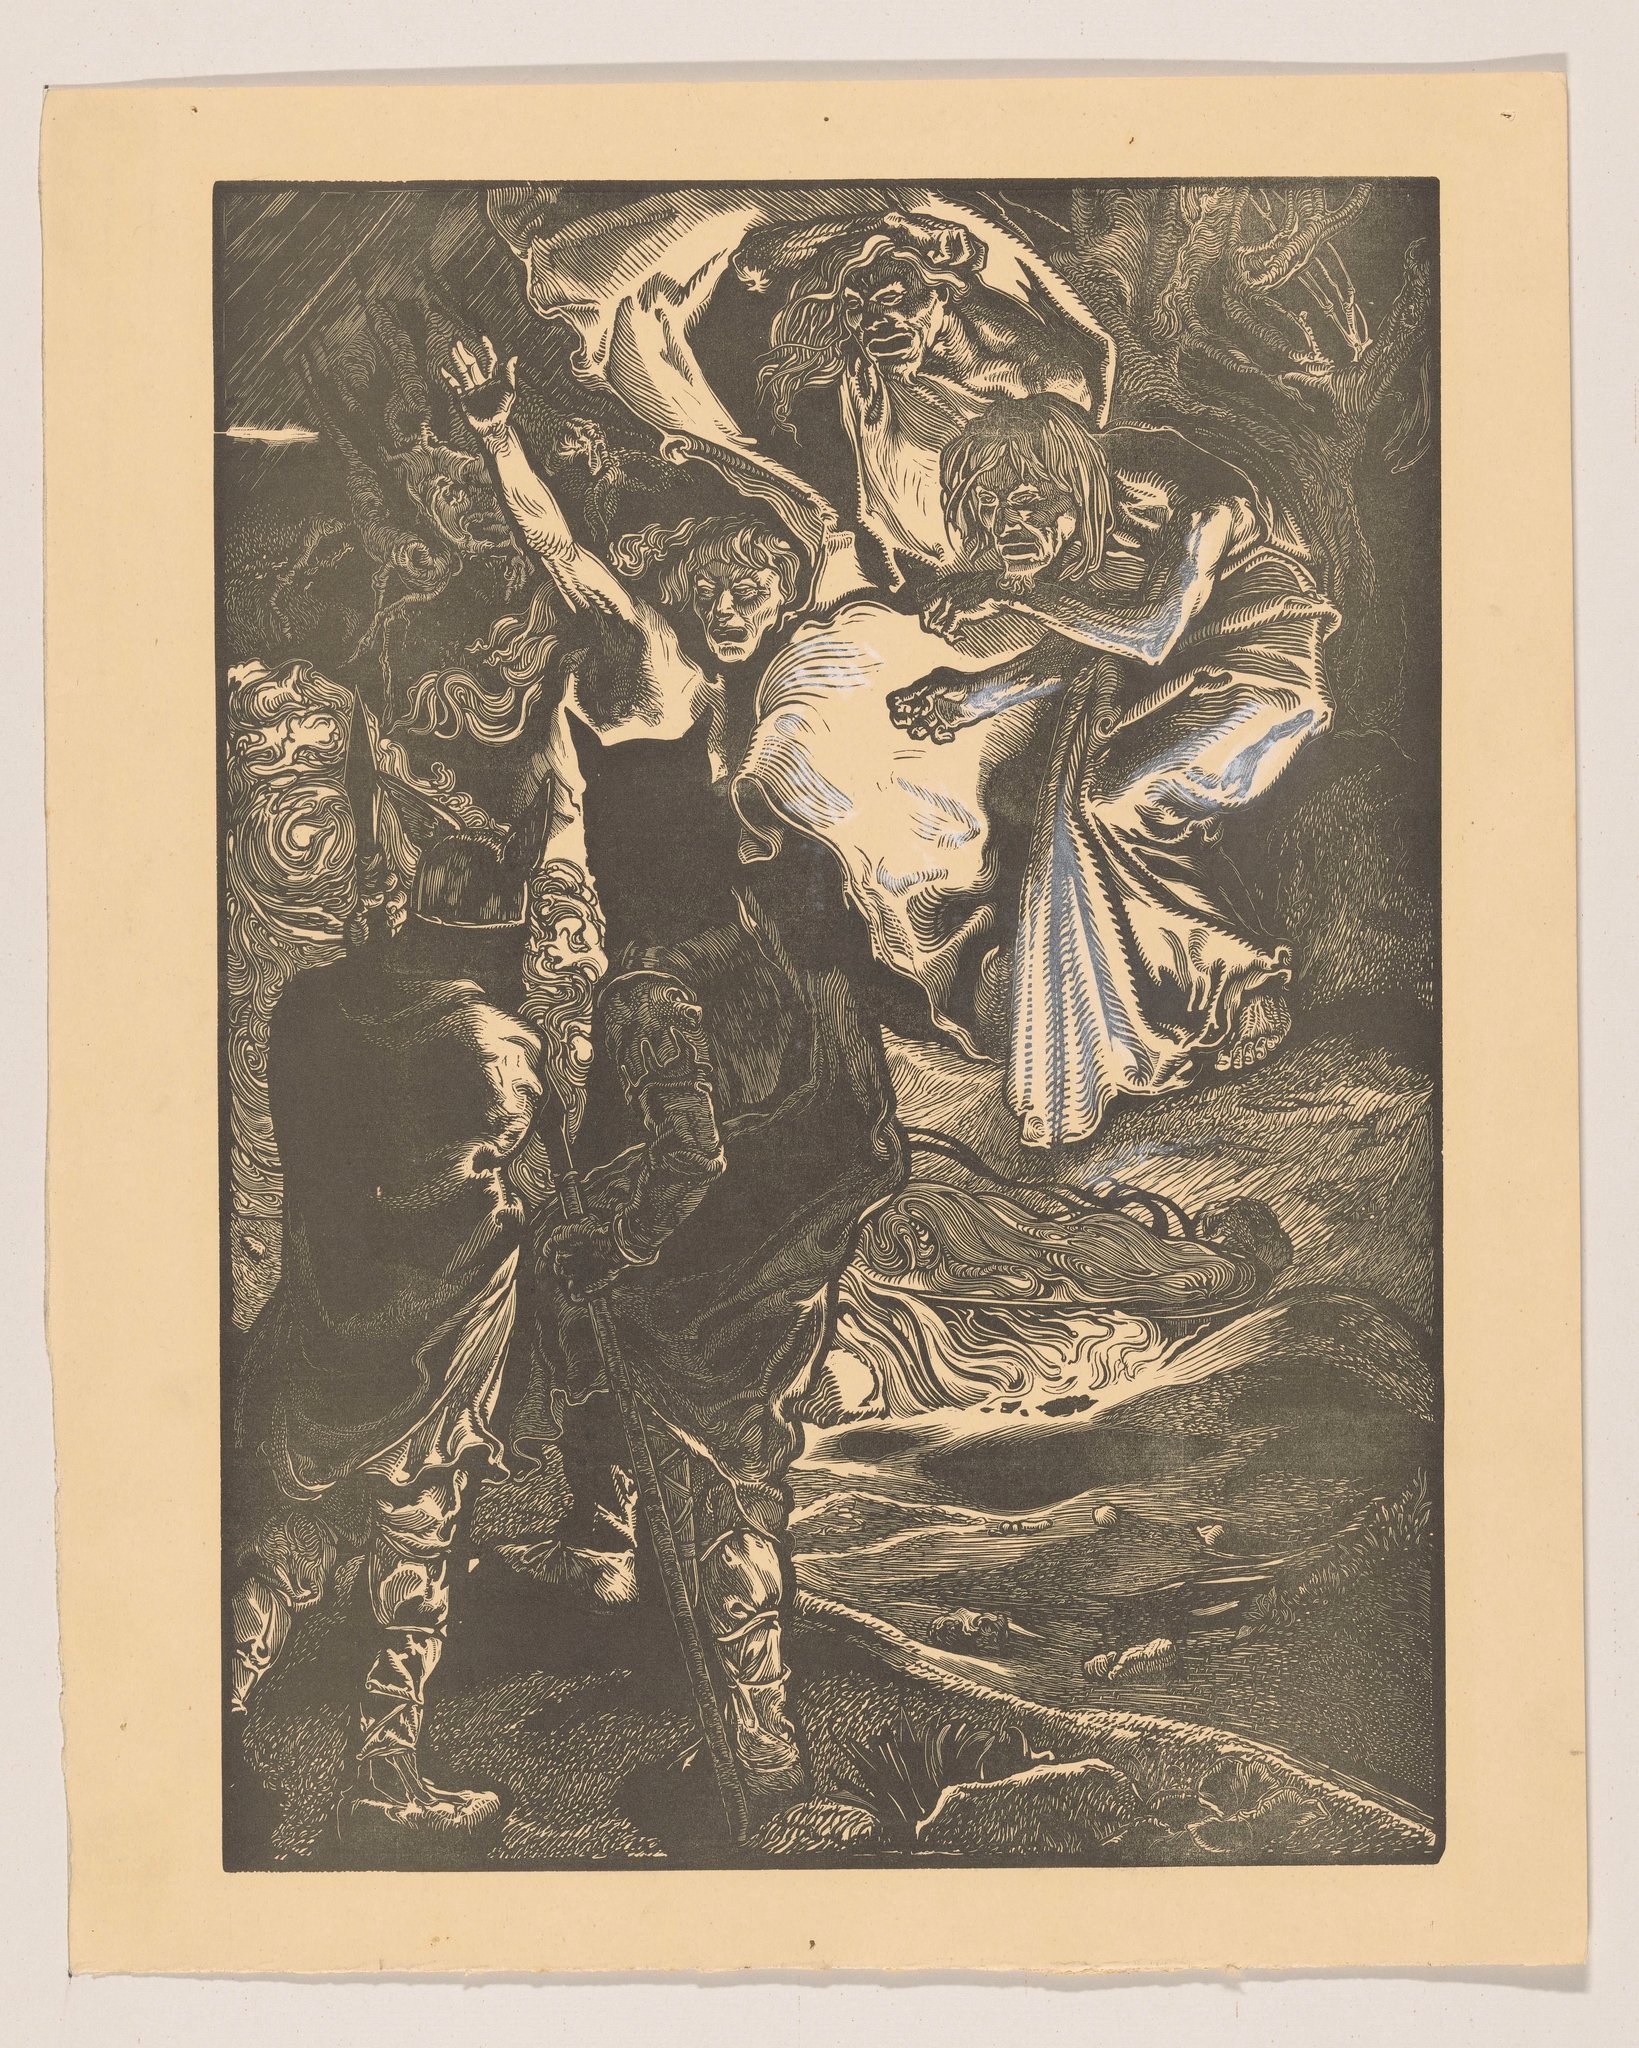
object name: print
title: Compositie met heksen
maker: johannes josephus aarts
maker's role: draughtsman, print maker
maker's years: 1871-1934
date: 1881-1934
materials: chalk, paper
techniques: woodcut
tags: groups of witches, macbeth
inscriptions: collector's mark: Lugt 2166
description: Linksonder Macbeth en zijn vriend Banquo, rechtsboven de drie heksen die voor elk van hen voorspellingen in petto hebben.